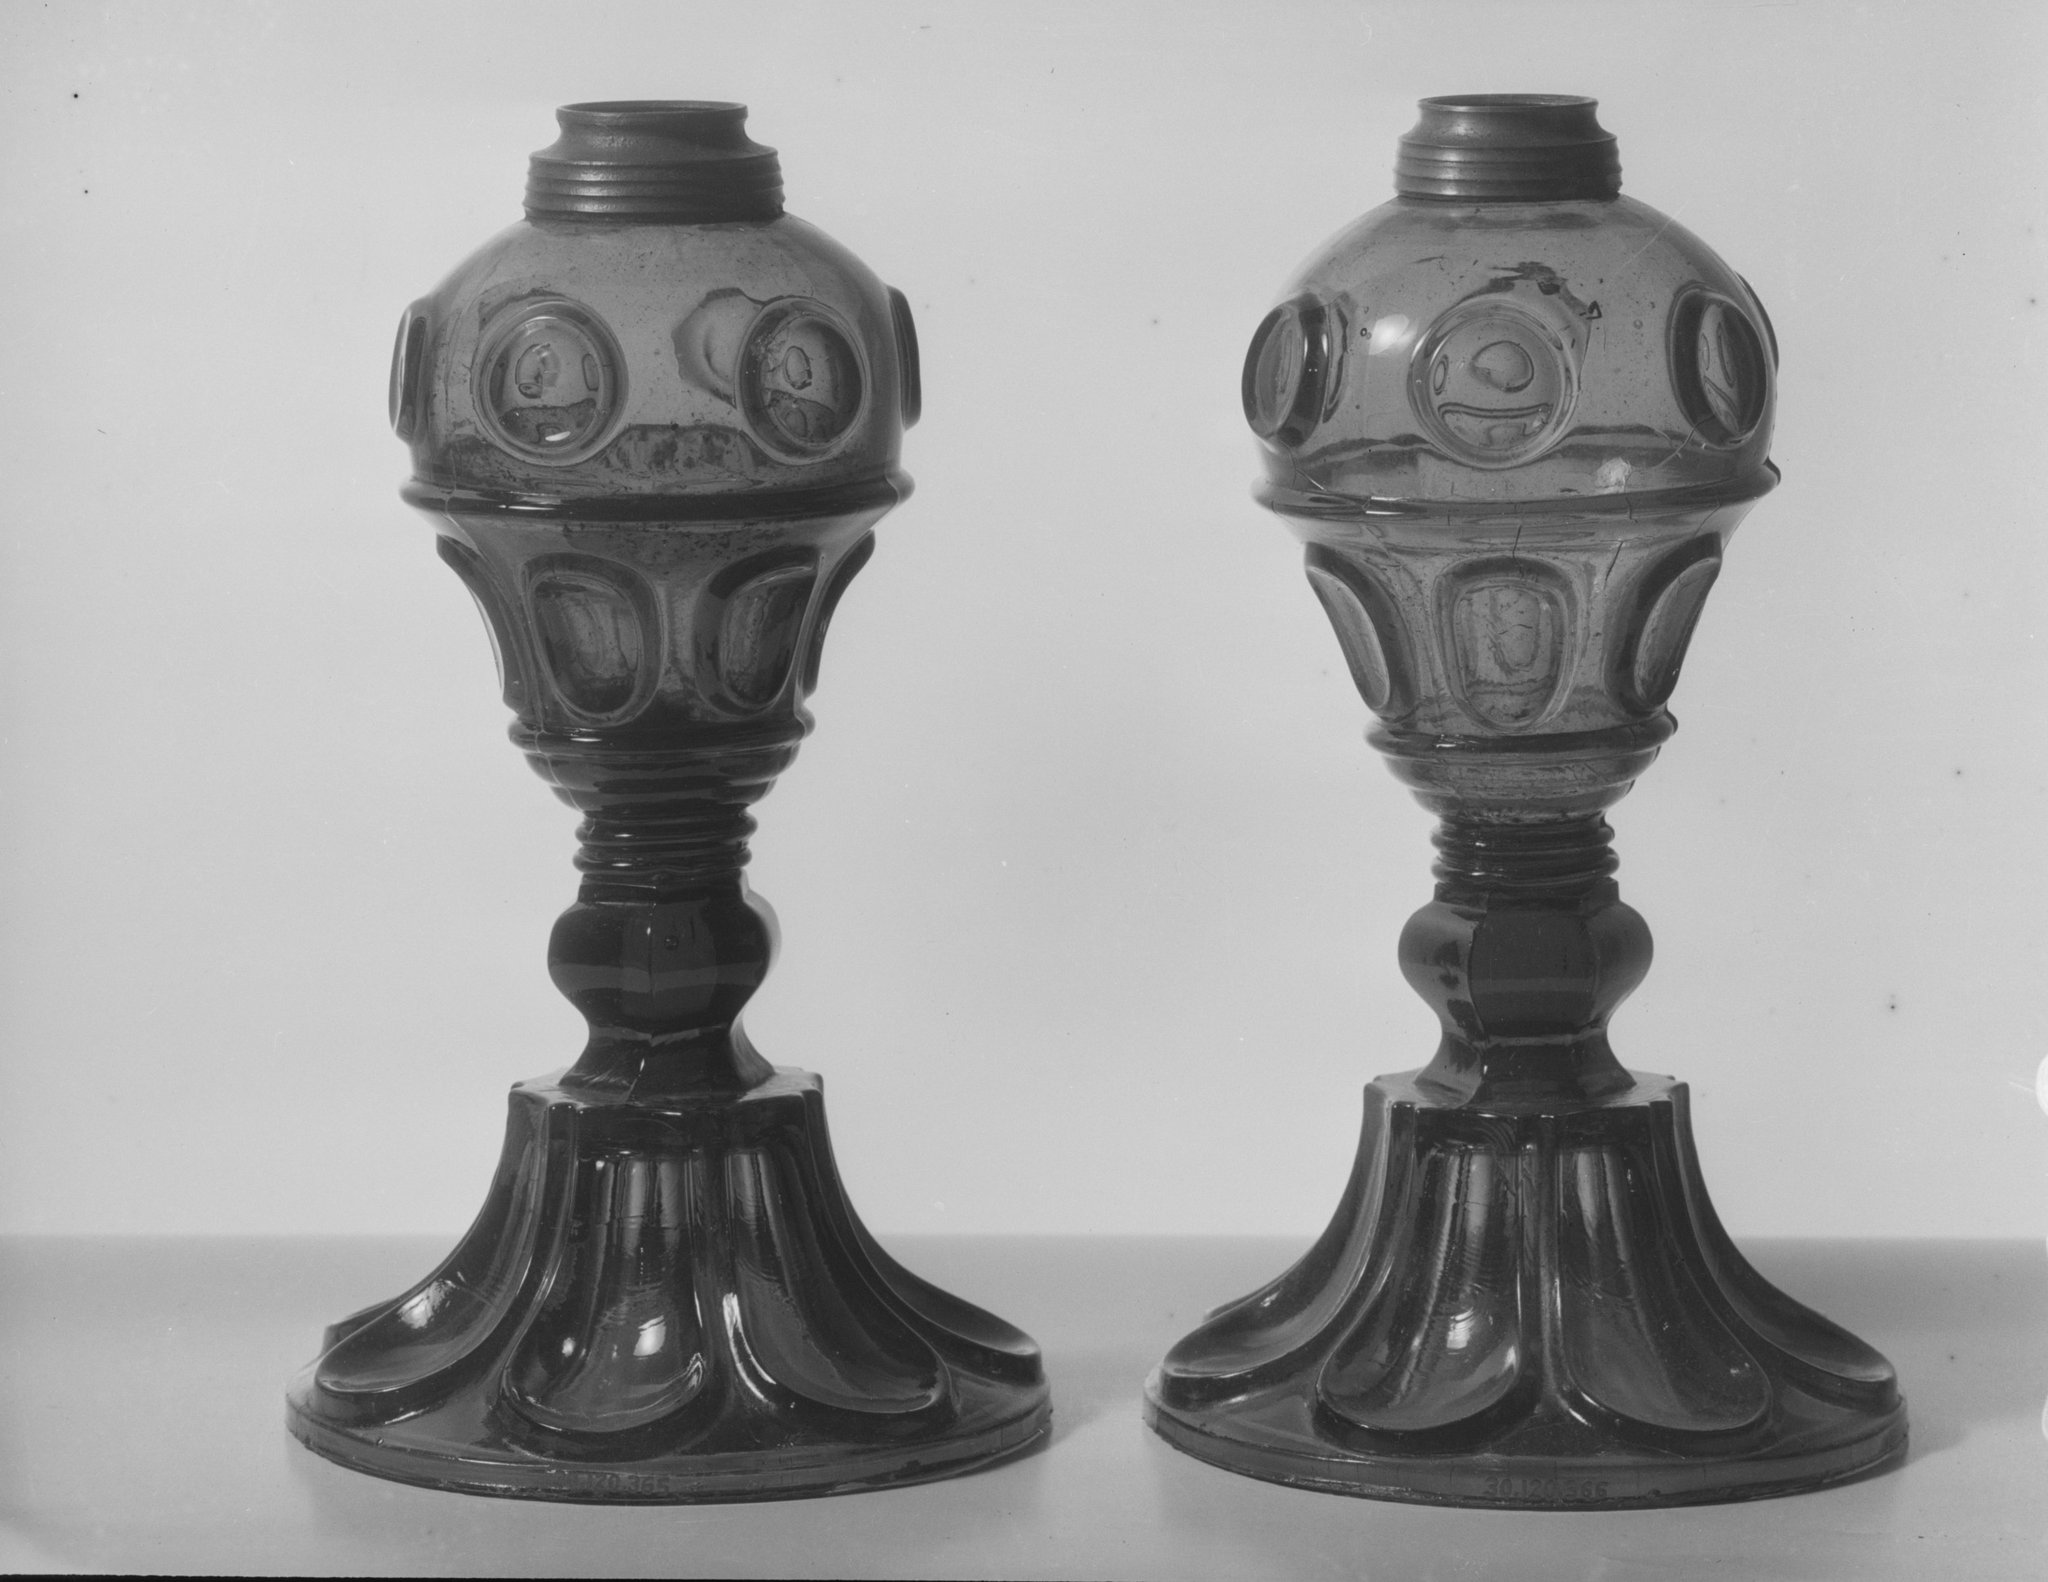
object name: oil lamp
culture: american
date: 1830-1900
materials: gemstone, glass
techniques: pressed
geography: united states